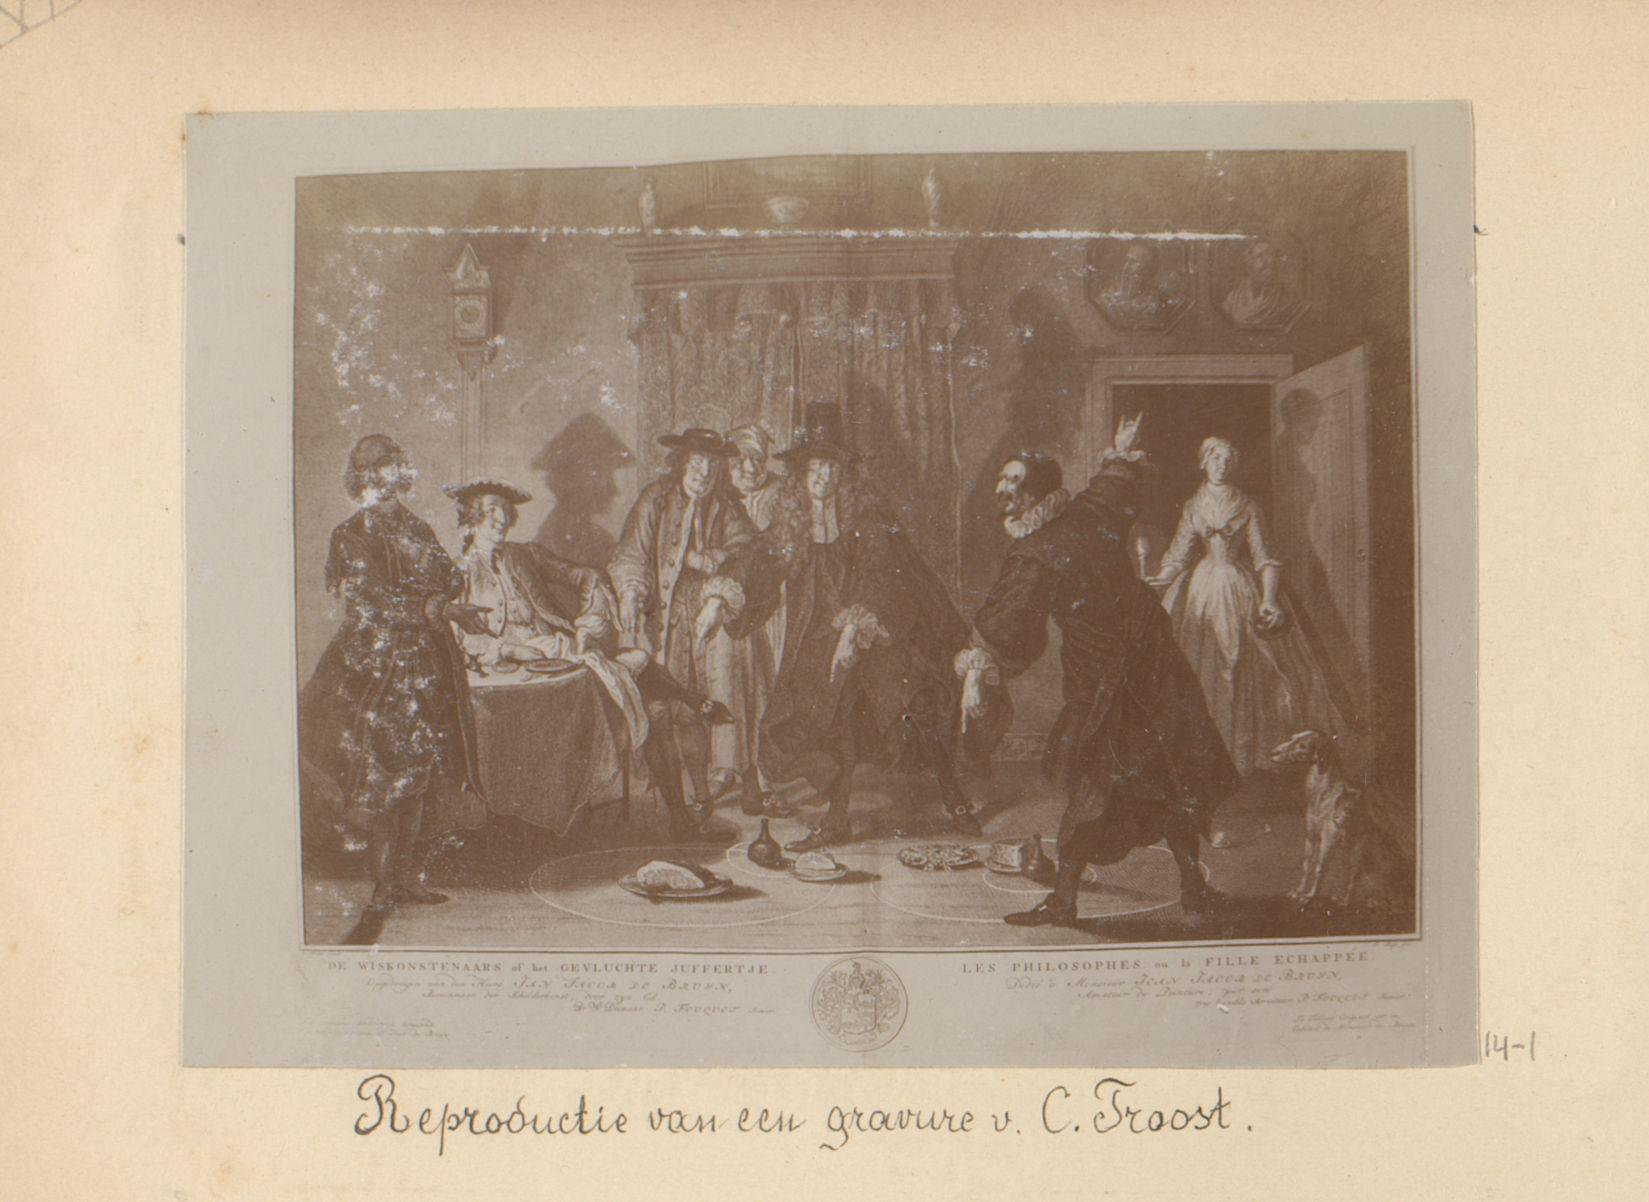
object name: reproduction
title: Reproductie van een gravure v. C. Troost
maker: hendrik herman van den berg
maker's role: amateurfotograaf, jurist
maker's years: 1875-1944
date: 1890-1894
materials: paper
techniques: collodion silver print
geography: amsterdam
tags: print, e.g.: engraving, etching, lithograph, amsterdam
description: Foto 1 op albumblad 14 uit album "Amsterdam 1890-1894". Reproductie van een gravure van Peter Tanjé naar het schilderij "De wiskonstenaars of het gevluchte juffertje" van Cornelis Troost.